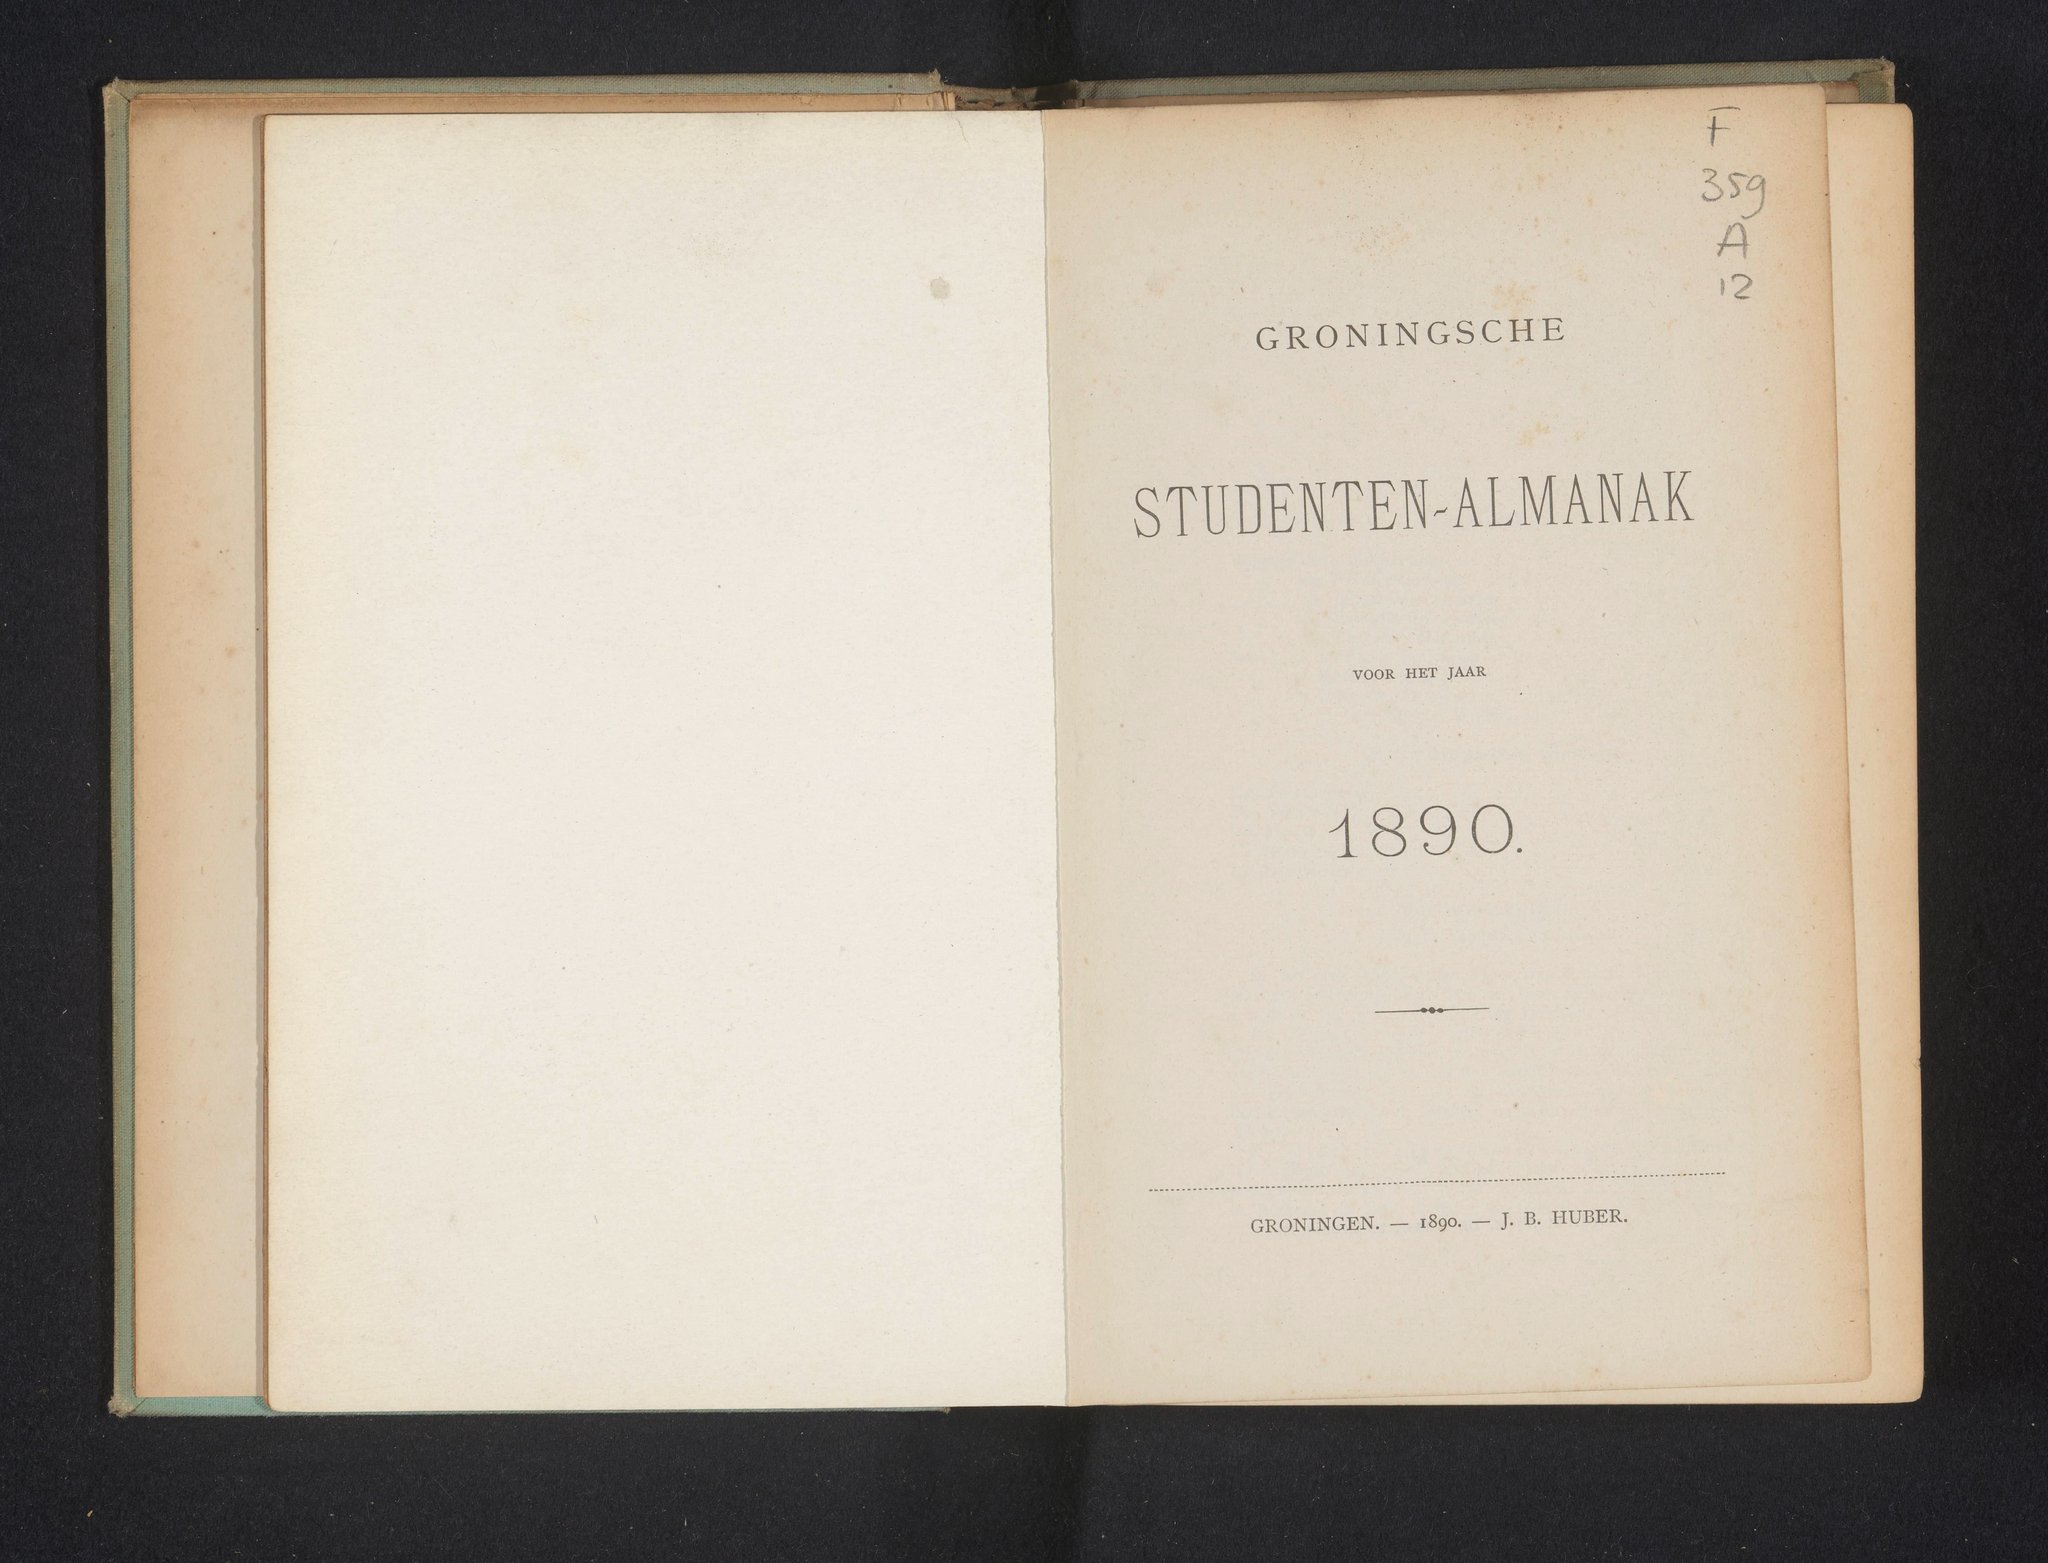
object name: book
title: Groninger studenten almanak voor het jaar 1890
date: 1890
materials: cardboard, linen, paper, photographic support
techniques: albumen print, lithograph, printing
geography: groningen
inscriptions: name: ‘Strasser’, annotation: ‘geruild met J. Strasser/ 7.3.39’